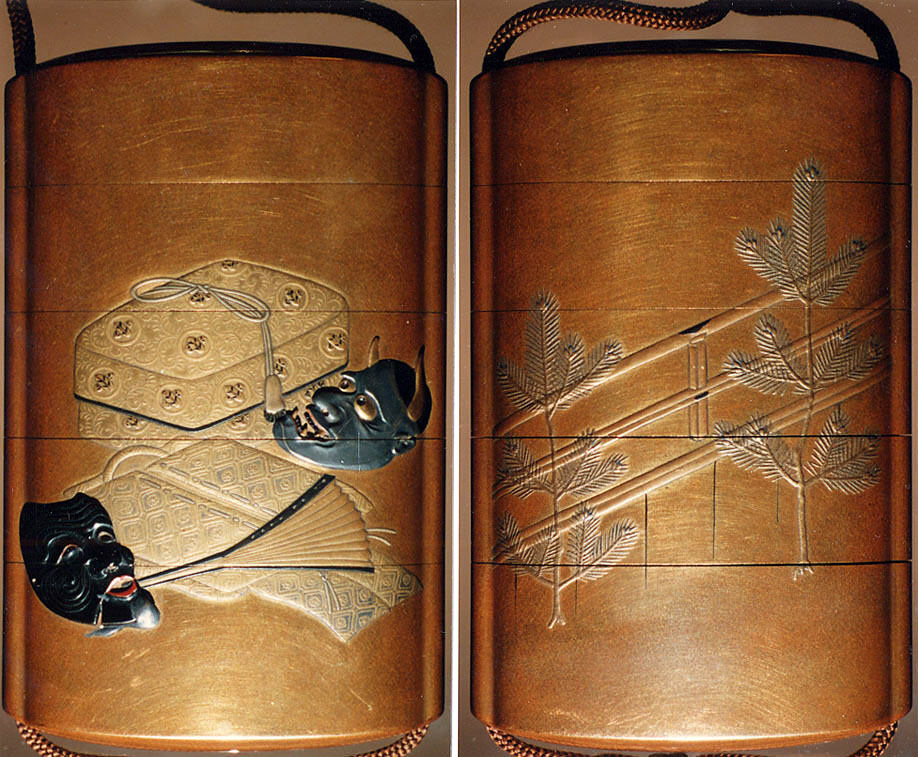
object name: inrō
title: Case (Inrō) with Design of Actor's Masks, Robe and Fan beside Tasseled Box (obverse); Young Pine Trees beside Stage (reverse)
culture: japanese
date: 1801-1900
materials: gold, lacquer, silver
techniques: fundame, hiramakie, maki-e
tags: masks,fans